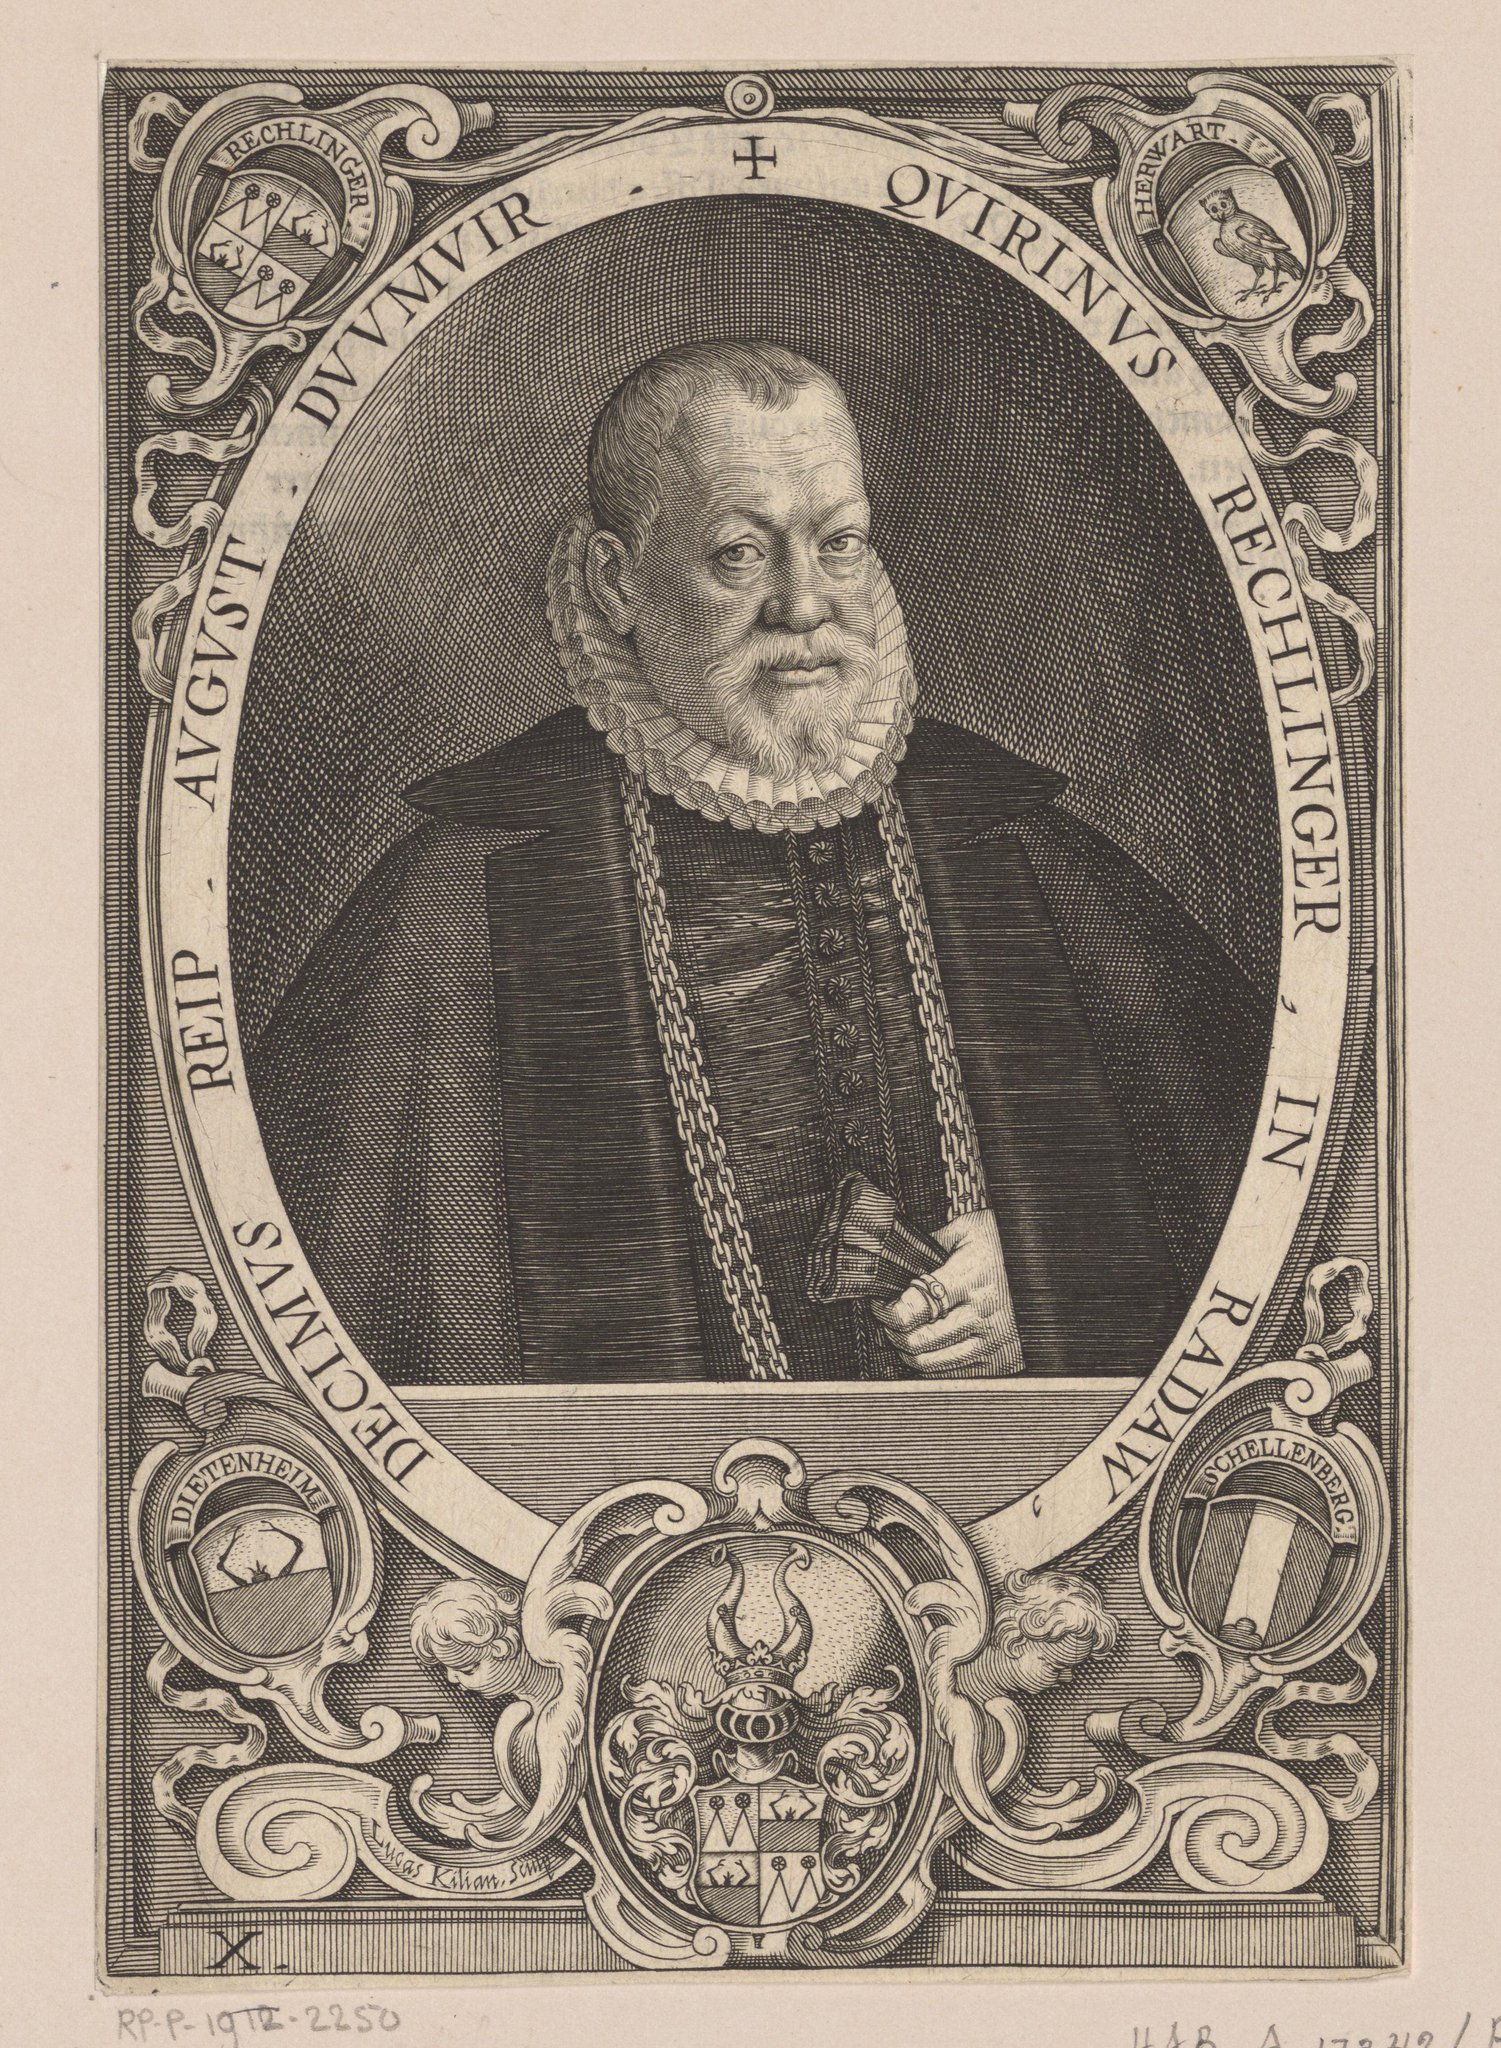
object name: print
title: Portret van Quirin Rehlinger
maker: lucas kilian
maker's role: draughtsman, print maker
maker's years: 1579-1637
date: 1615-1624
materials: paper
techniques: engraving, letterpress printing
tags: historical persons, armorial bearing, heraldry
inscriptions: collector's mark: Lugt 2228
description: Prent mogelijk uit: Kilian, Lucas. Icones Omnium (...) Duumvirum, quotquot a prima Cardina Institutione usque ad praesentia Tempore Aerae Christ.M.DXCV. vixere. Augsburg: Lucas Kilian, 1615. Of uit een latere editie (1624).